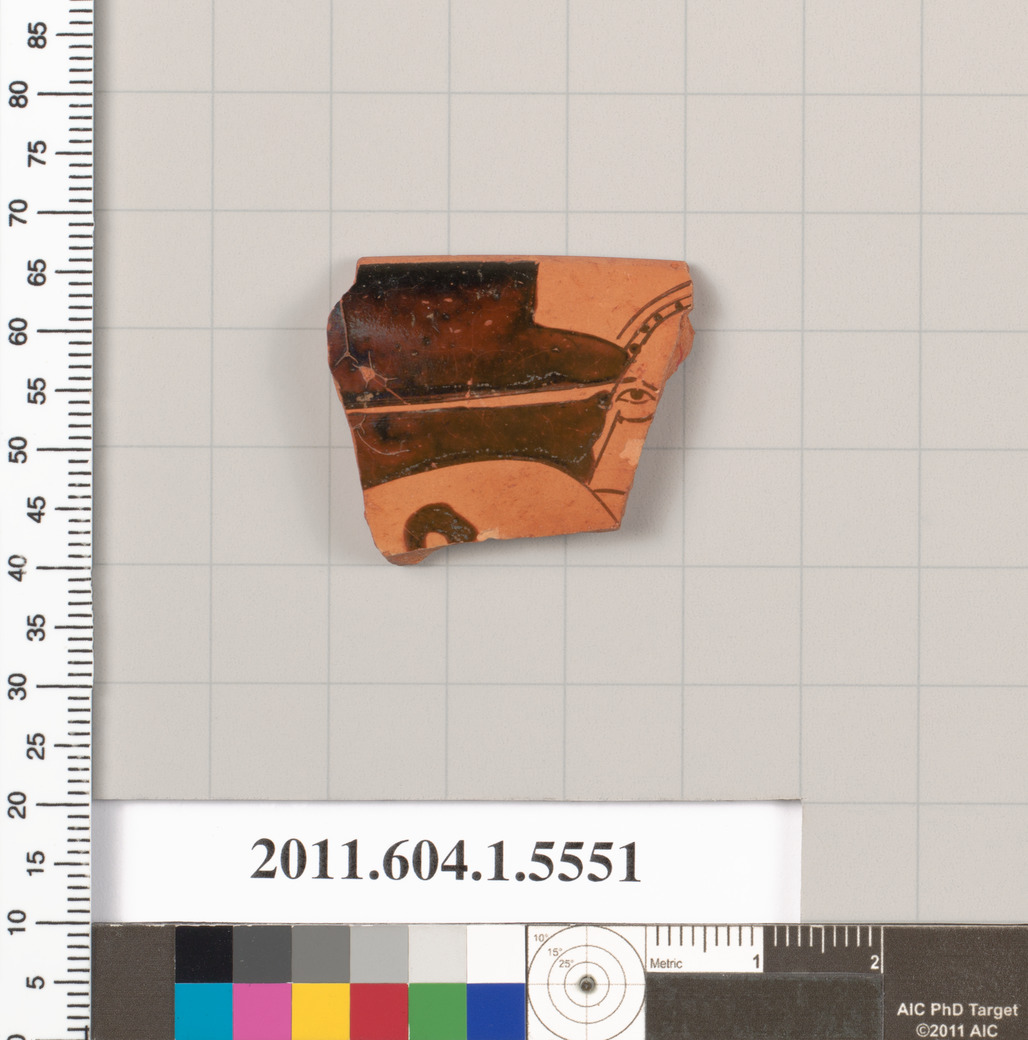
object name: kylix fragment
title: Terracotta rim fragment of a kylix (drinking cup)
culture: greek, attic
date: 520-500 BCE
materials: terracotta